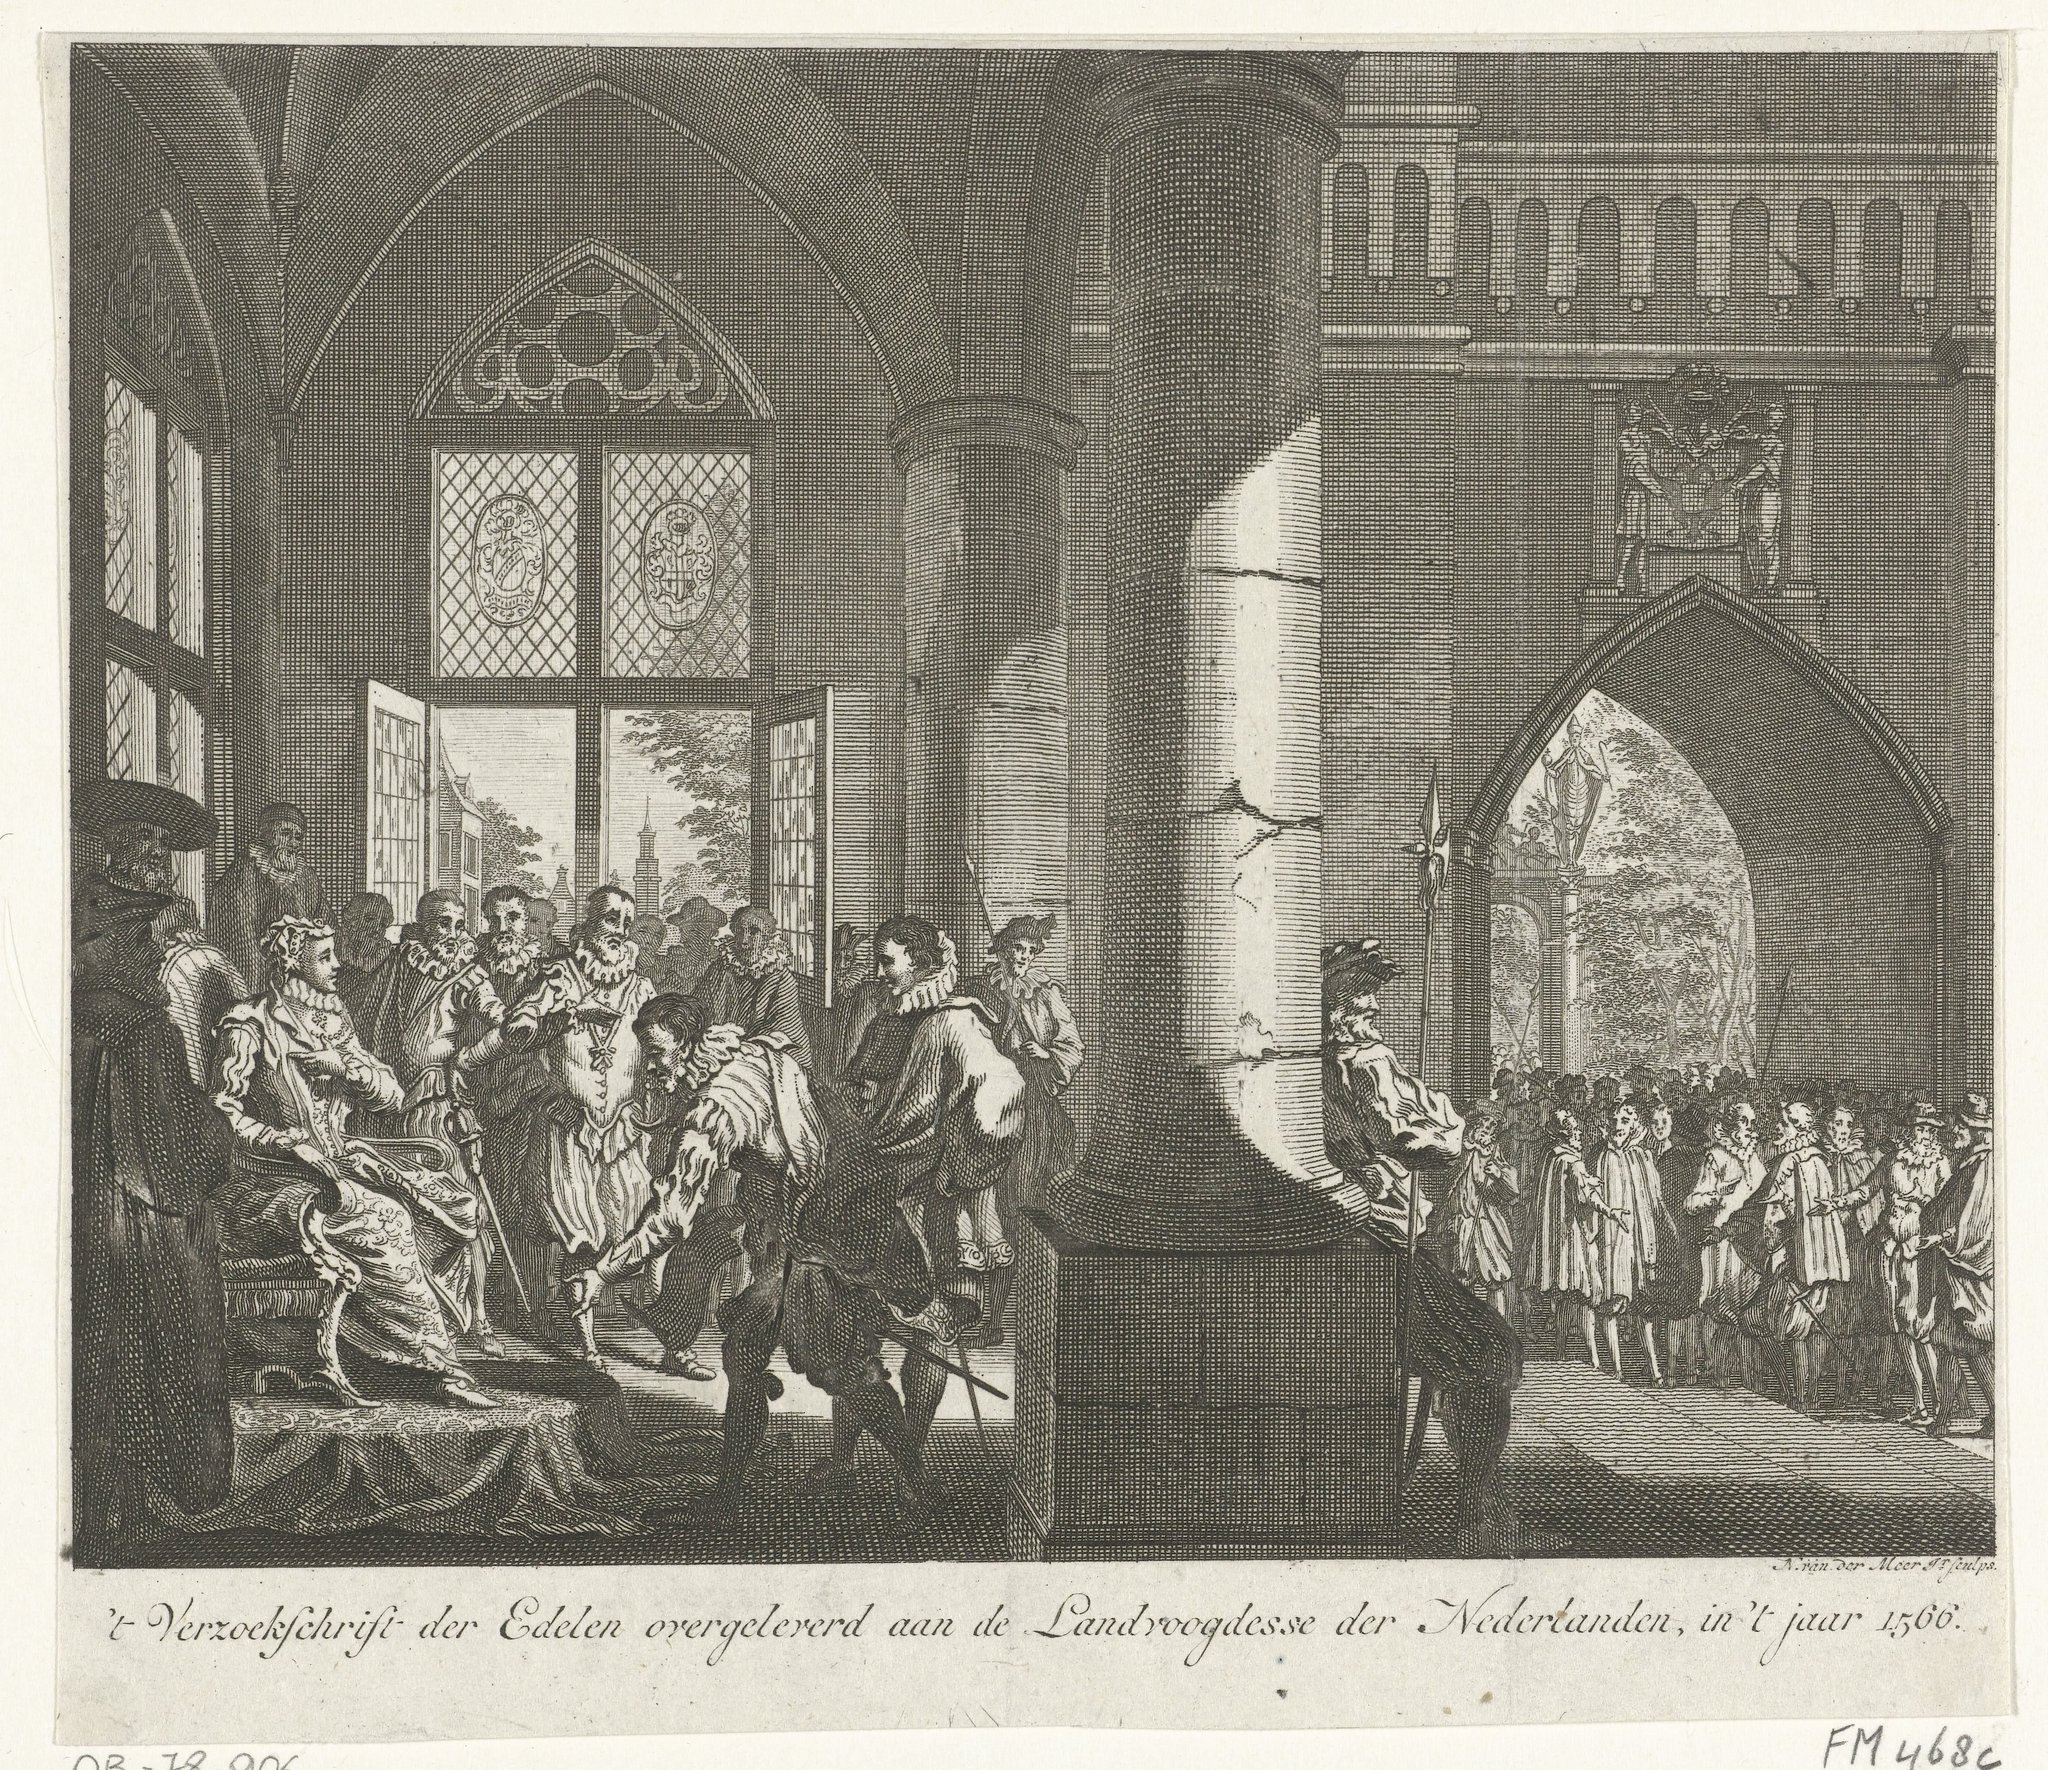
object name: history print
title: Het aanbieden van het Smeekschrift aan de hertogin van Parma, 1566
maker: noach van der meer (ii)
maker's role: draughtsman, print maker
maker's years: 1741-1822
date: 1752-1822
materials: paper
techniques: etching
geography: netherlands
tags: hendrik van brederode (heer van vianen), oudenaarde, ortona, landvoogd, landvoogdes der nederlanden margaretha van parma, paleis op de koudenberg, smeekschrift der edelen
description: Kopie naar de illustratie van S. Fokke in: Jan Wagenaar, Vaderlandsche historie, Amsterdam 1749-1759. Niet in Frederik Muller; door het RPK toegevoegd nummer.